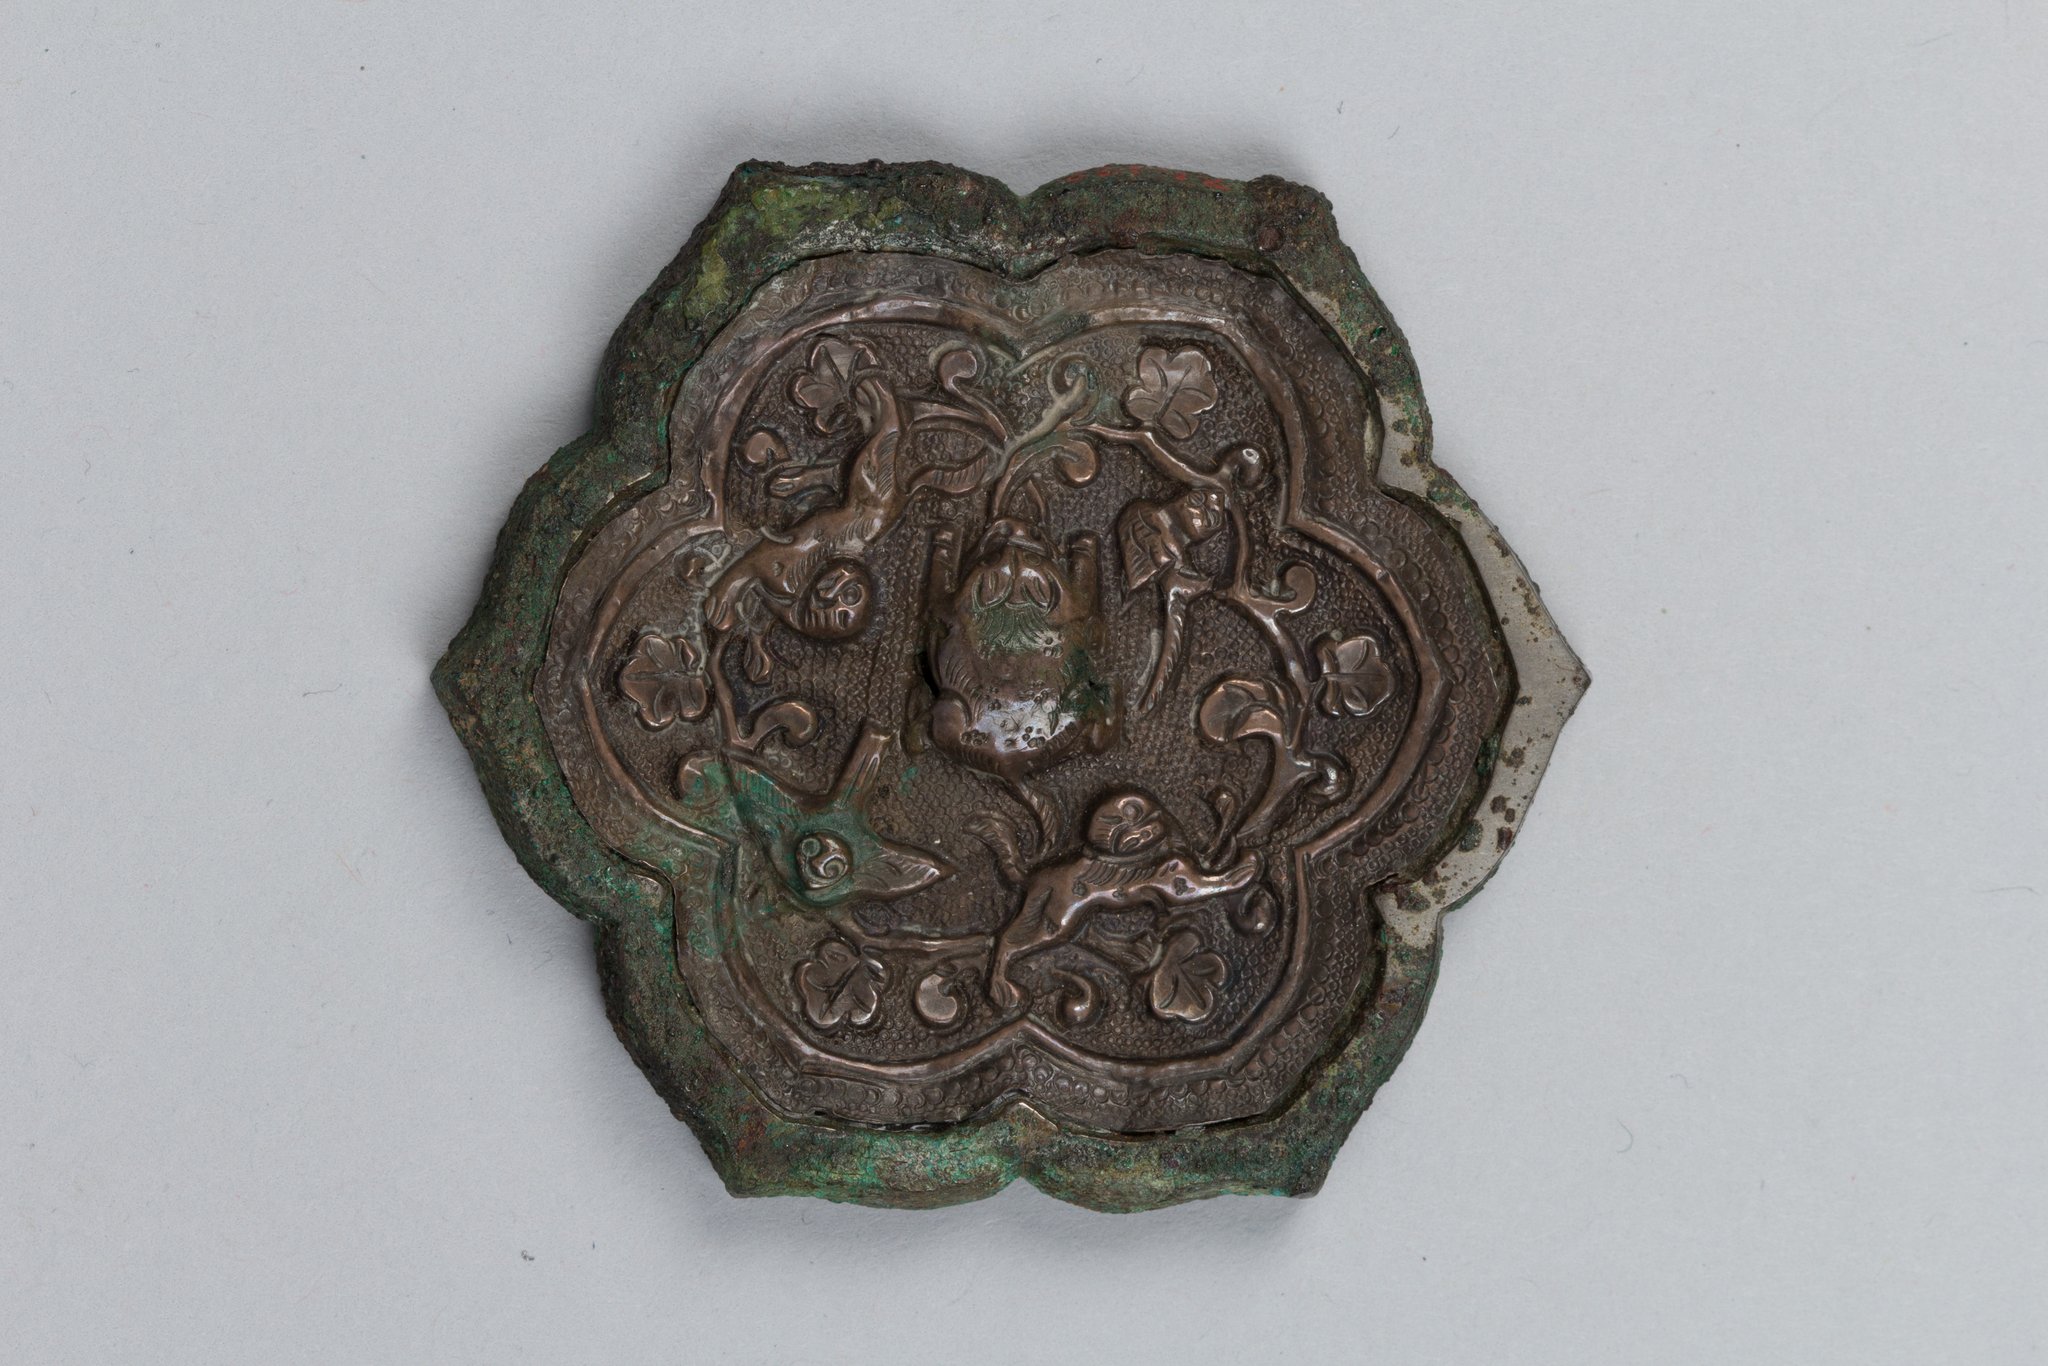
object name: mirror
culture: chinese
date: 618-1911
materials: bronze, silver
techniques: repoussé